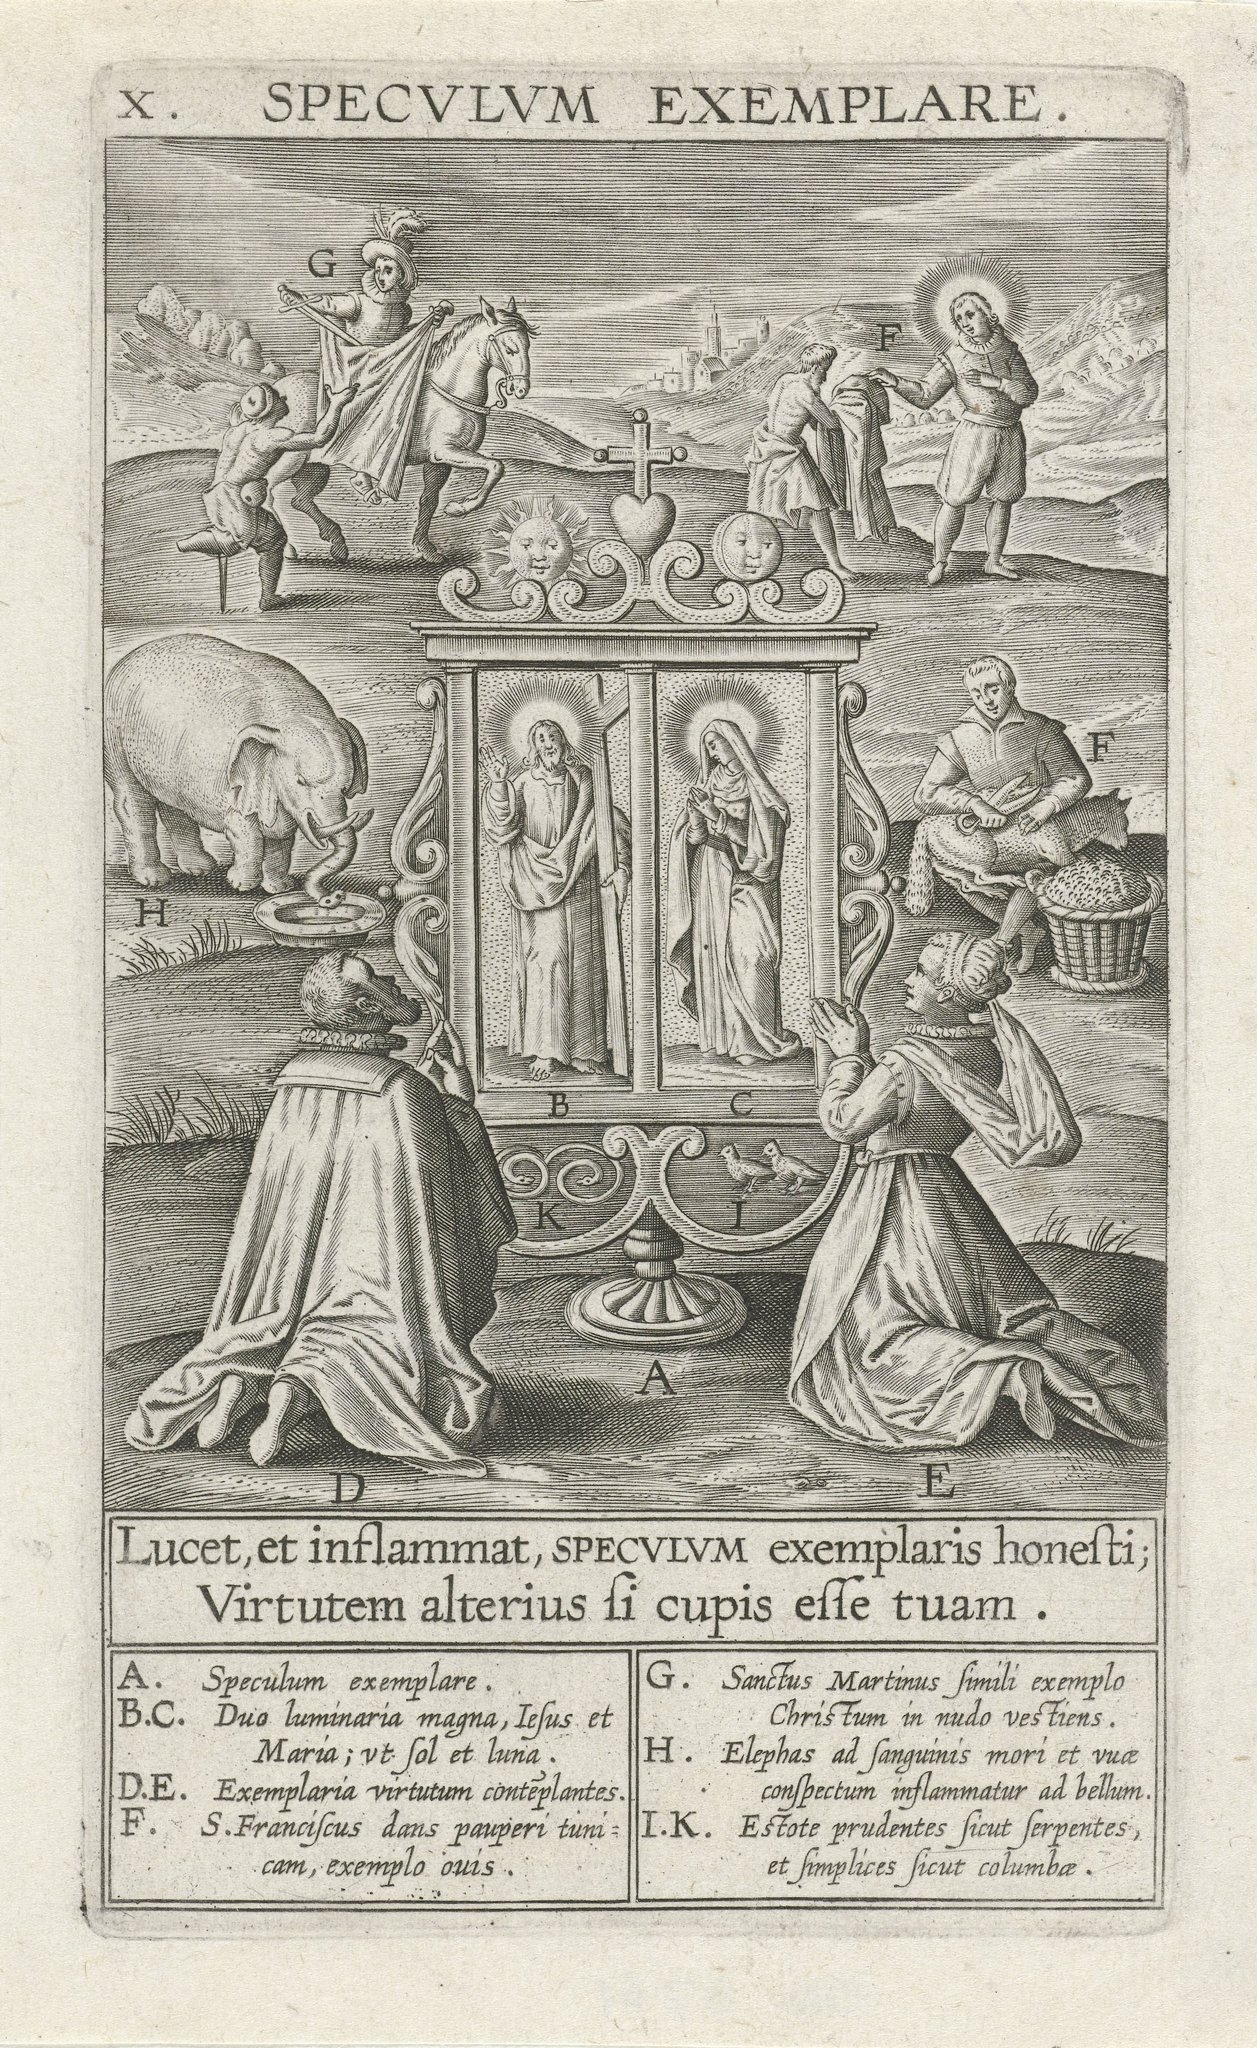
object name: book illustration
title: Duodecim Specula Deum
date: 1610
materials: paper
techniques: engraving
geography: antwerp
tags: st. martin divides his cloak (i.e. the charity of st. martin): he is usually shown on horseback, cutting his cloak with his sword, or putting part of the cloak round the shoulders of a beggar who kneels beside him, mirror, founder of the order of friars minor (franciscans), francis(cus) of assisi; possible attributes: book, crucifix, lily, skull, stigmata, private worship and religious study, trunked animals: elephant (+ animals used symbolically), shearing (sheep), portable altar (+ christ), portable altar (+ mary)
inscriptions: collector's mark: Lugt 2228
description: Op de voorgrond twee gelovigen. Ze knielen voor een spiegeldiptiek, die de reflectie van Christus en Maria toont. In de achtergrond toonbeelden van devotie: de heilige Maarten en de heilige Franciscus die hun mantels aan bedelaars geven en een olifant als teken van wijsheid.. De prent heeft een Latijns onderschrift: 'Lucet, et inflammat, Specvlvm exemplaris honesti; Virtutem alterius si cupis esse tuam'. Onderaan een legende van de scènes die op de afbeelding alfabetisch genummerd zijn. De prent is deel van een twaalfdelige serie (X uit XII prenten) met als onderwerp twaalf spiegels waarmee de mens God probeert te zien.